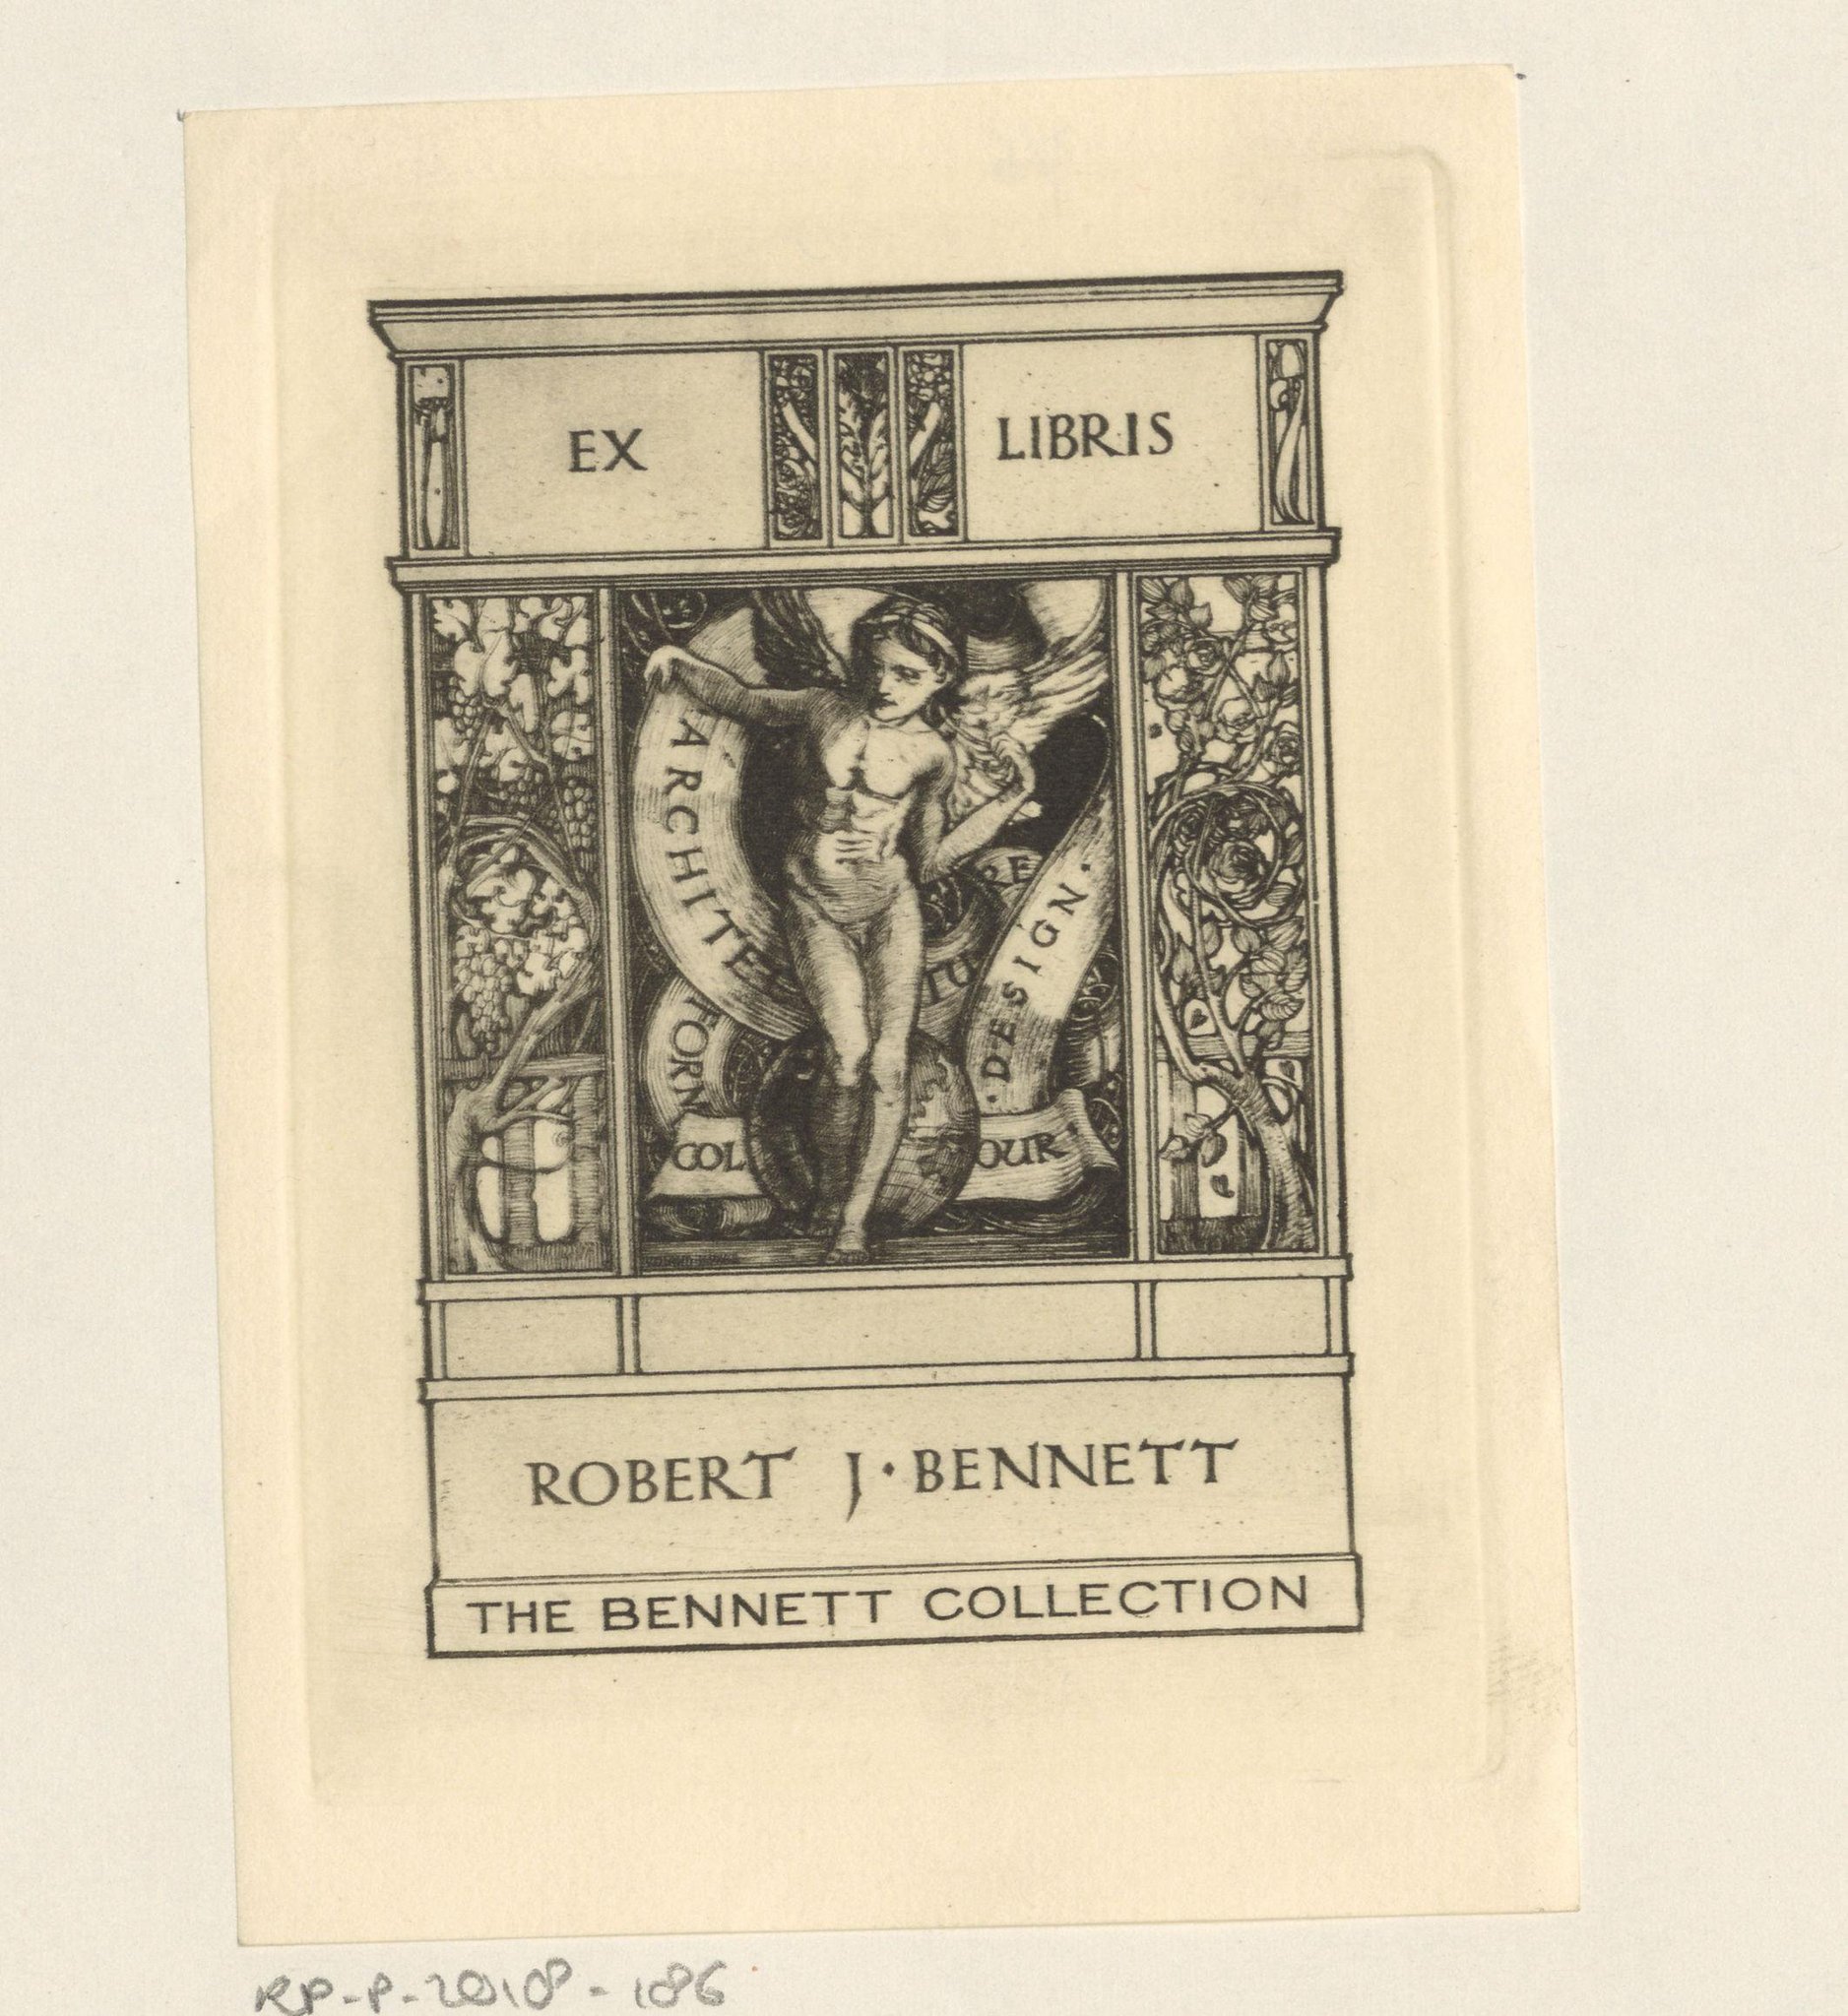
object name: photomechanical print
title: Ex libris van Robert J. Bennett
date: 1880-1949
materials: paper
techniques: photoaquatint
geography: north and central america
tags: vine, flowers: rose, angels, man (showing himself) undressed, quasi-nude